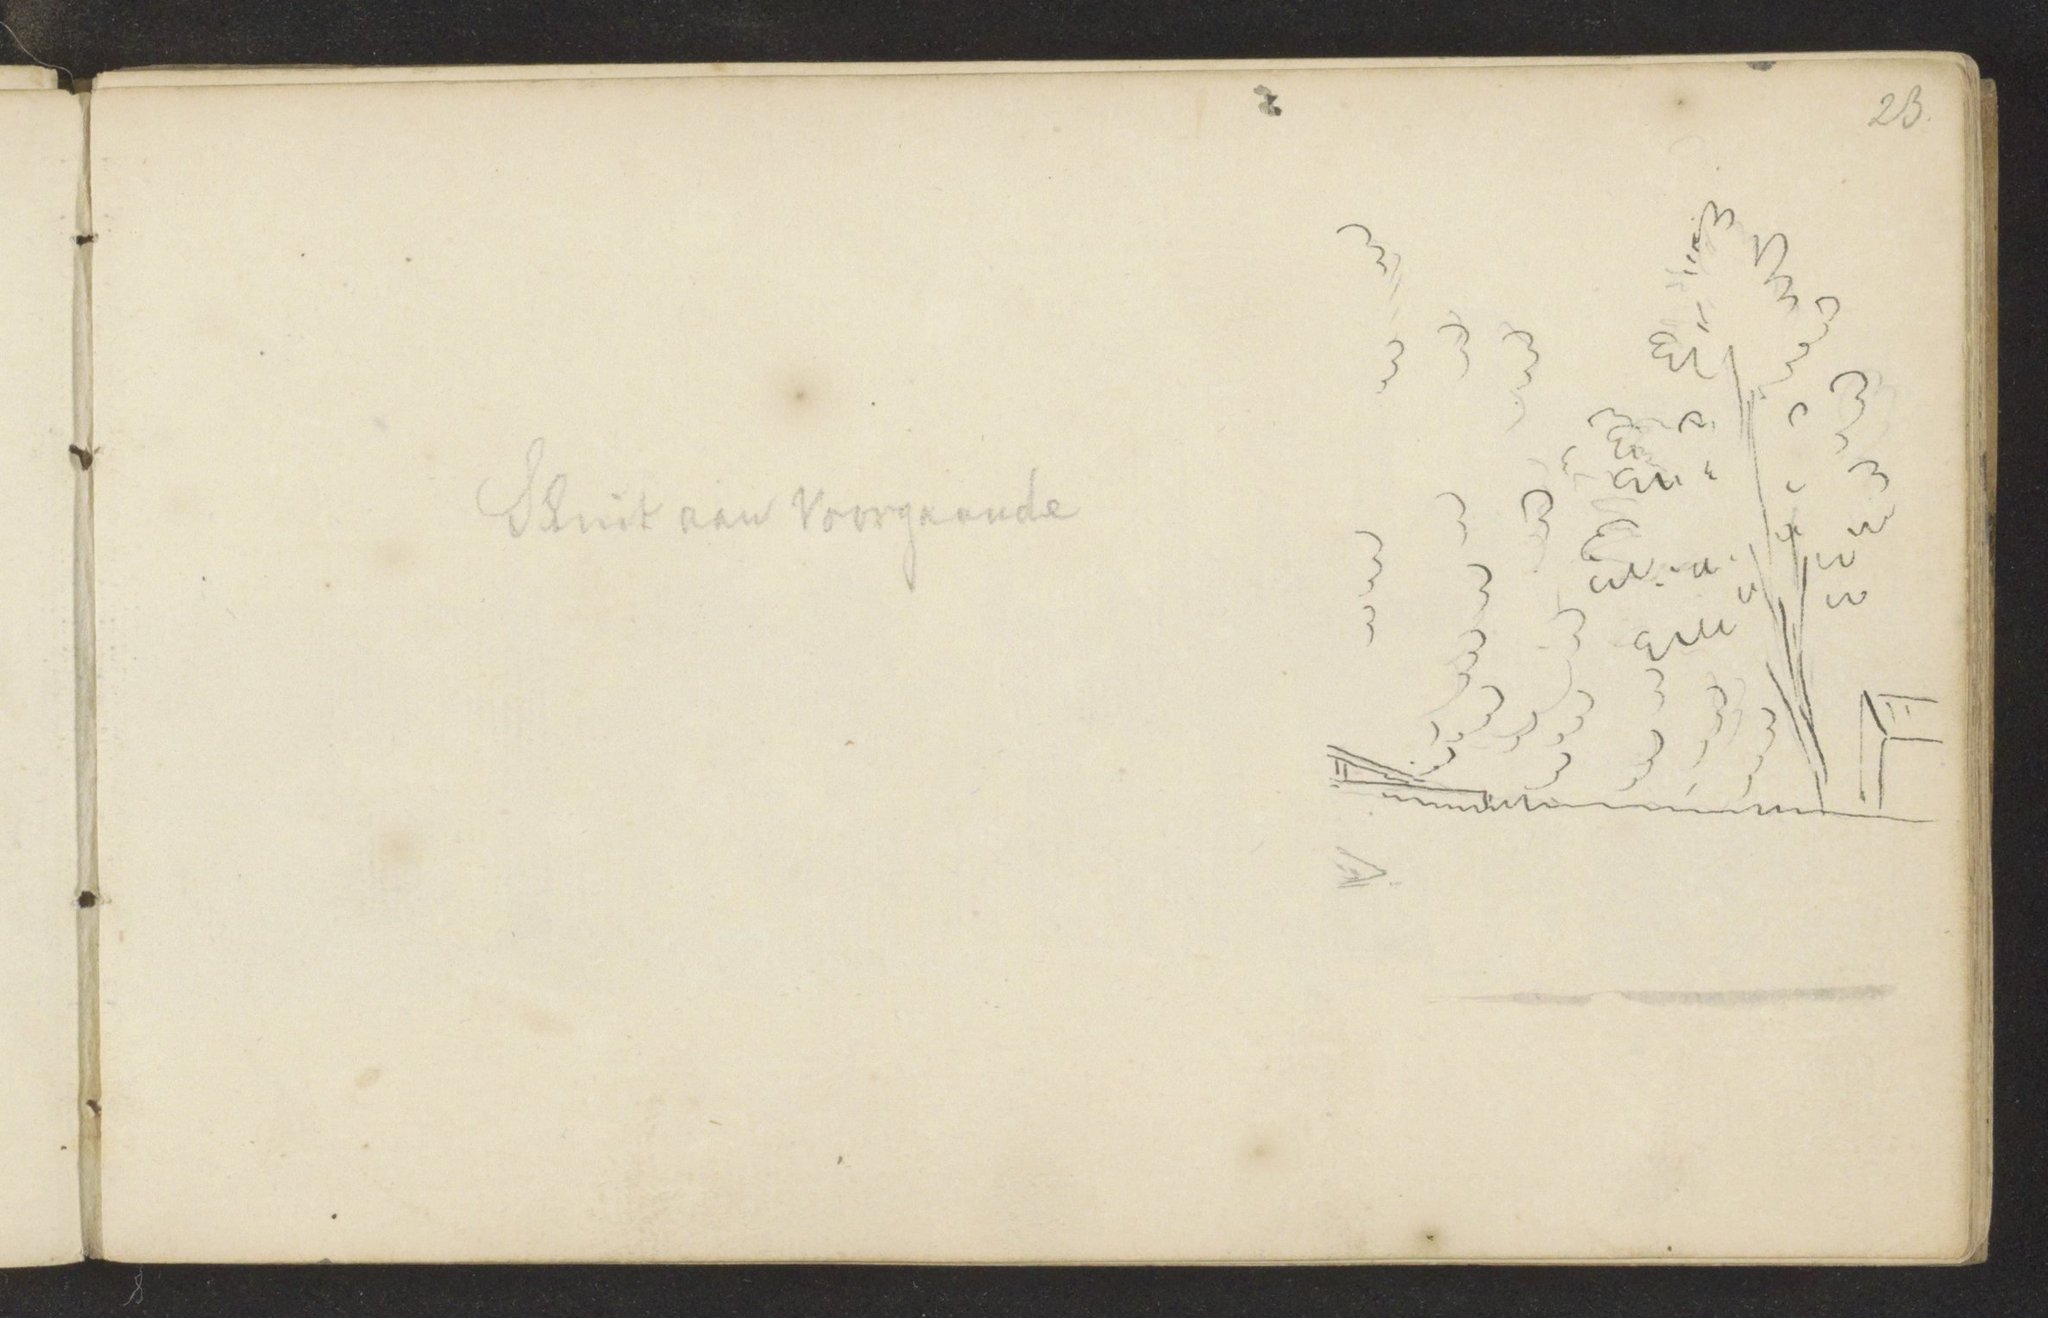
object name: sketchbook leaf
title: Brug en kade te Voorhout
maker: abraham de haen (ii)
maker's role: draughtsman, print maker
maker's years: 1707-1748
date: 1731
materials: ink, paper, pencil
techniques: brush, pen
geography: voorhout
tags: village, bridge in village across river, canal, etc.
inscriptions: annotation: ‘sluit aan voorgaande’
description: Vervolg van de schets op blad 22 recto. Blad 23 recto uit een schetsboek met 78 bladen.